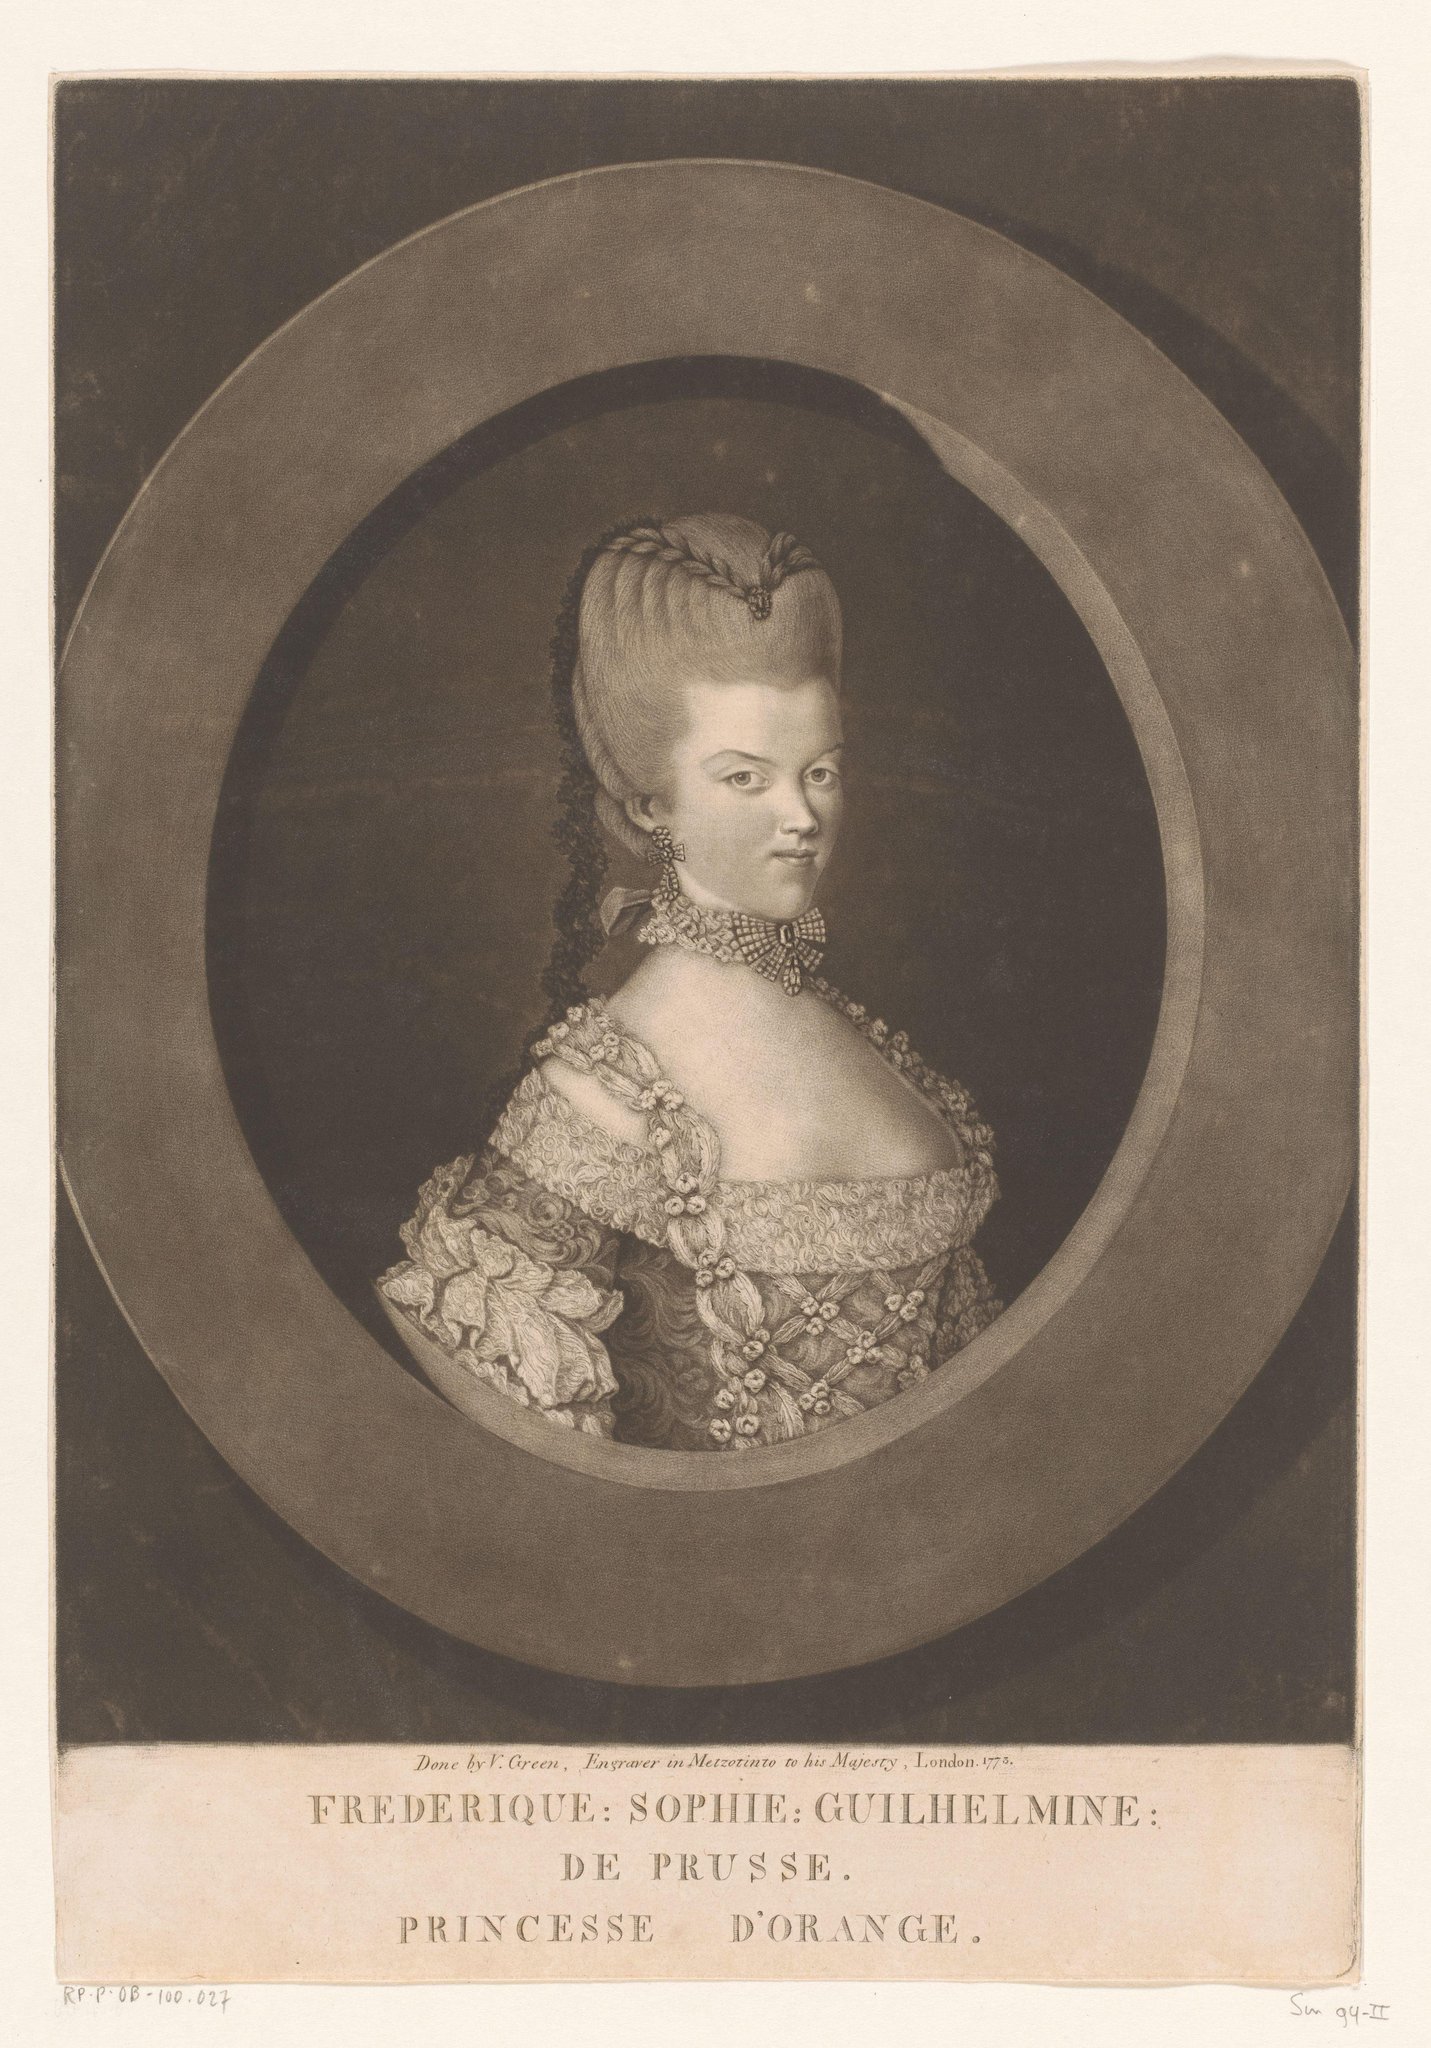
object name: print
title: Frederique Sophie Guilhelmine / De Prusse / Princesse D'Orange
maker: valentine green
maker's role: print maker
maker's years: 1739-1813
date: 1775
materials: paper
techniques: etching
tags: draughtsman, wilhelmina of prussia (princess of orange), historical persons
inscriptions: collector's mark: Lugt 2228